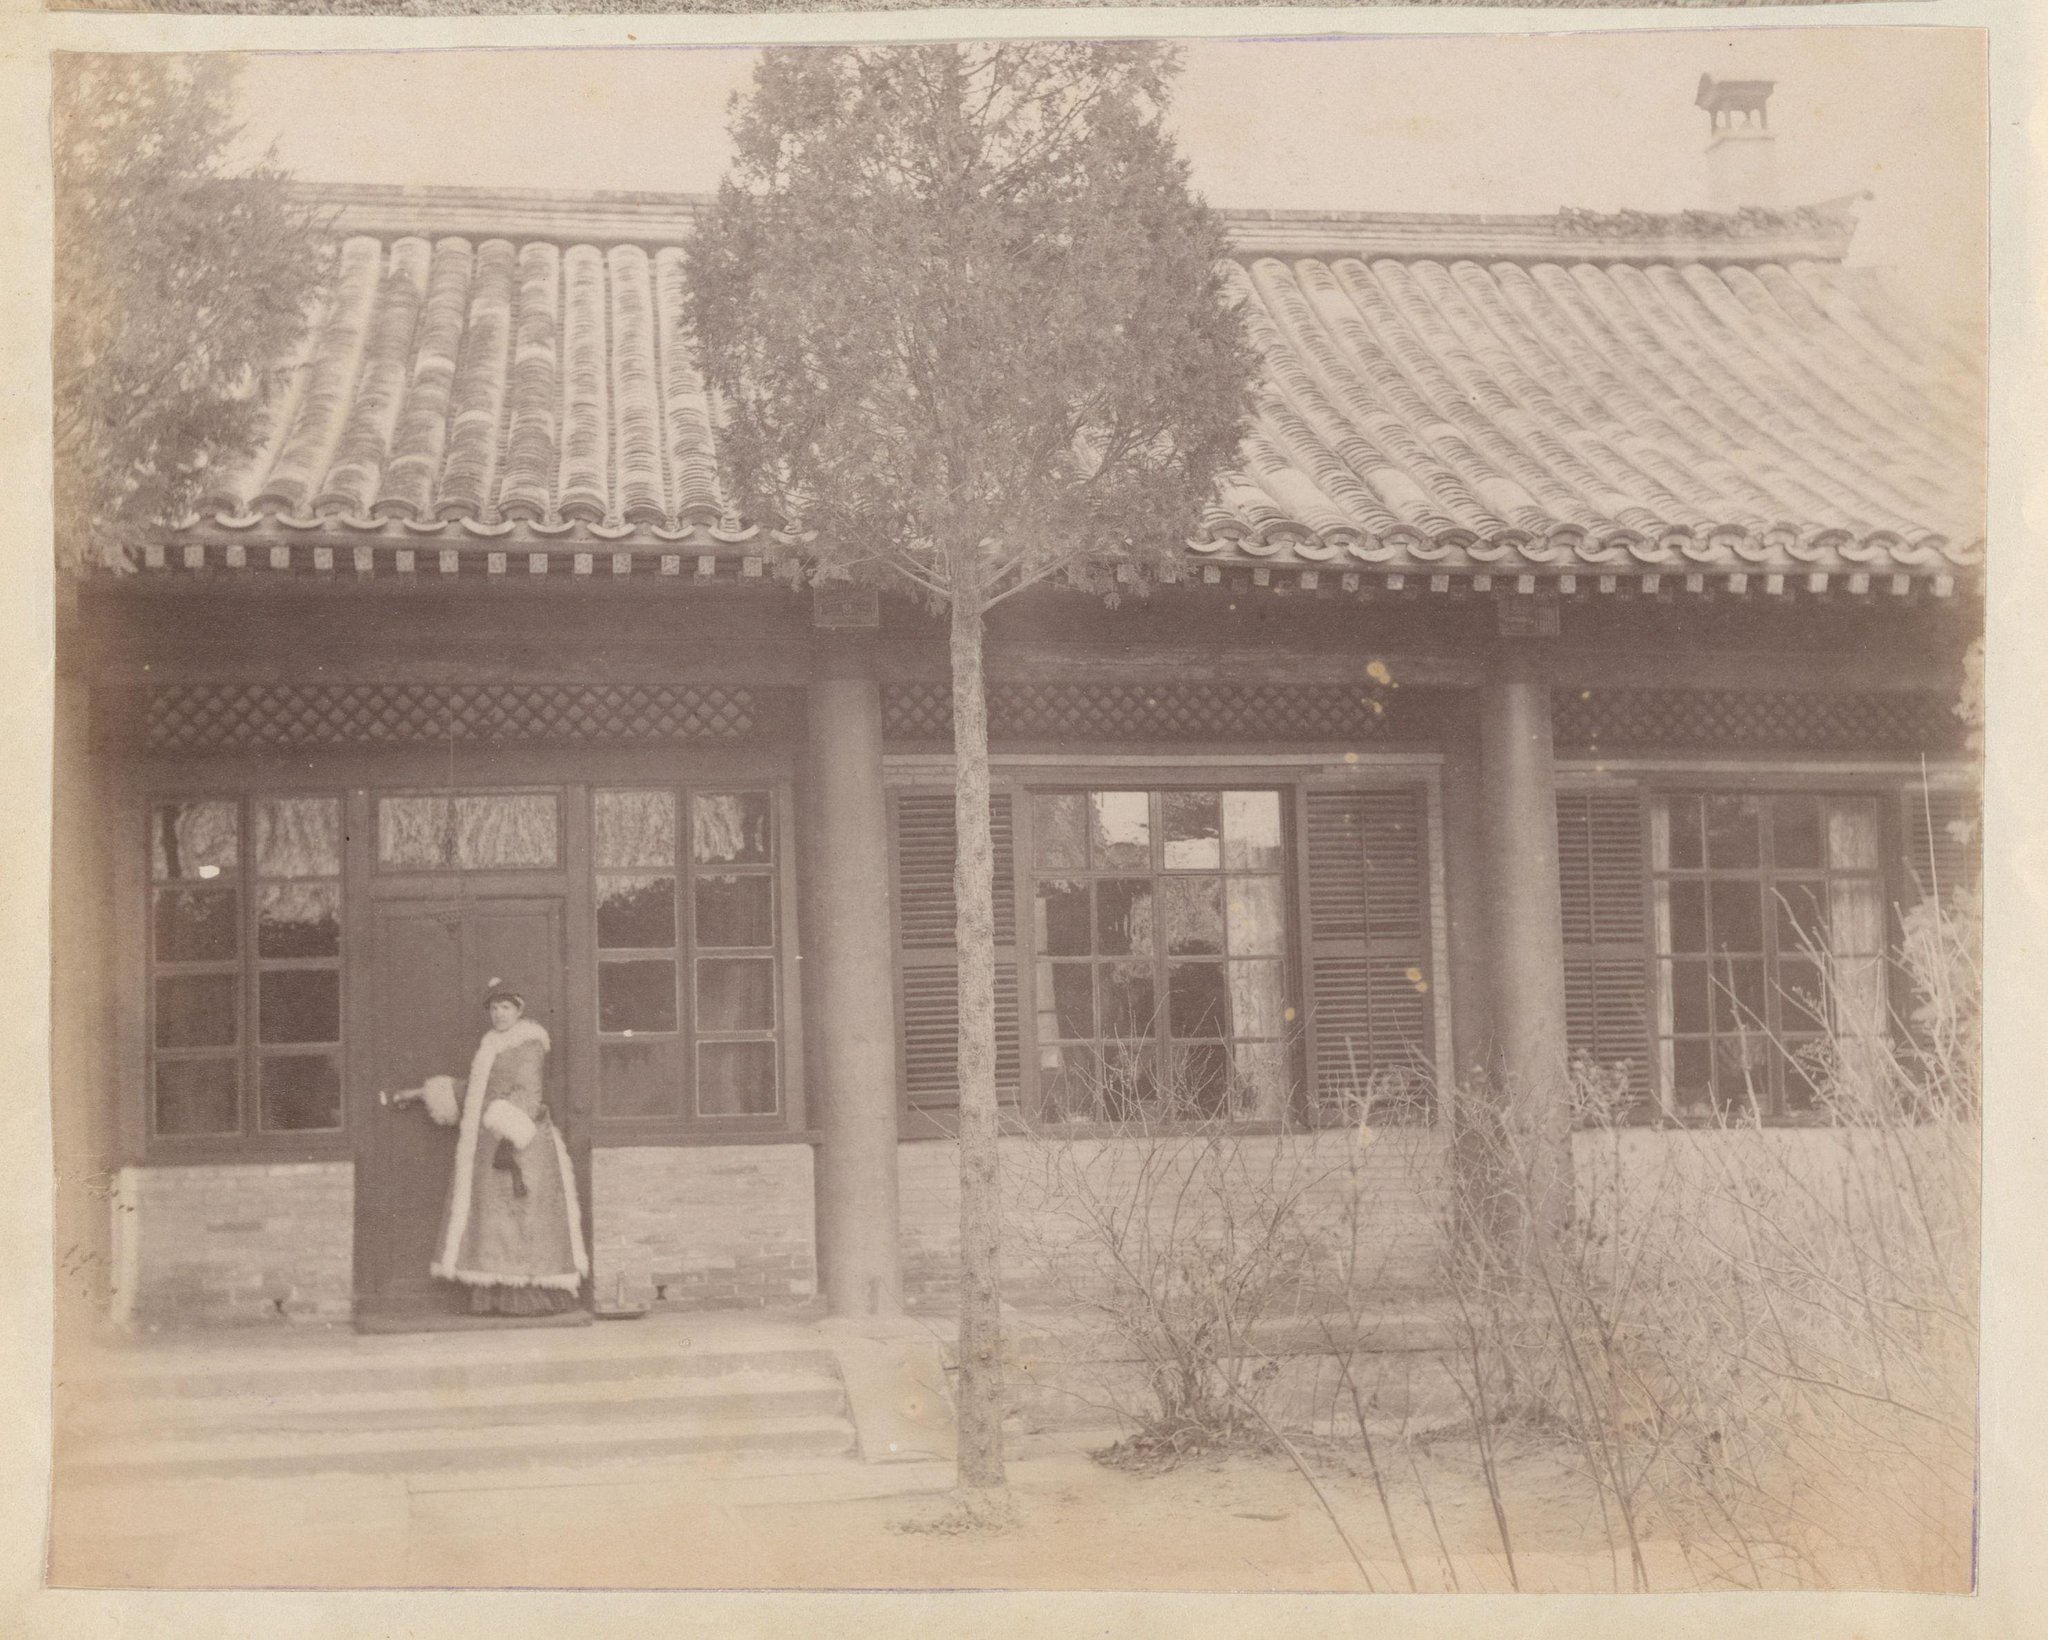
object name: album leaf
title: Vrouw in winterjas bij de deur van een Chinees huis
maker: Anonymous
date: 1879-1890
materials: paper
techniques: albumen print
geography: china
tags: urban housing, coat, china